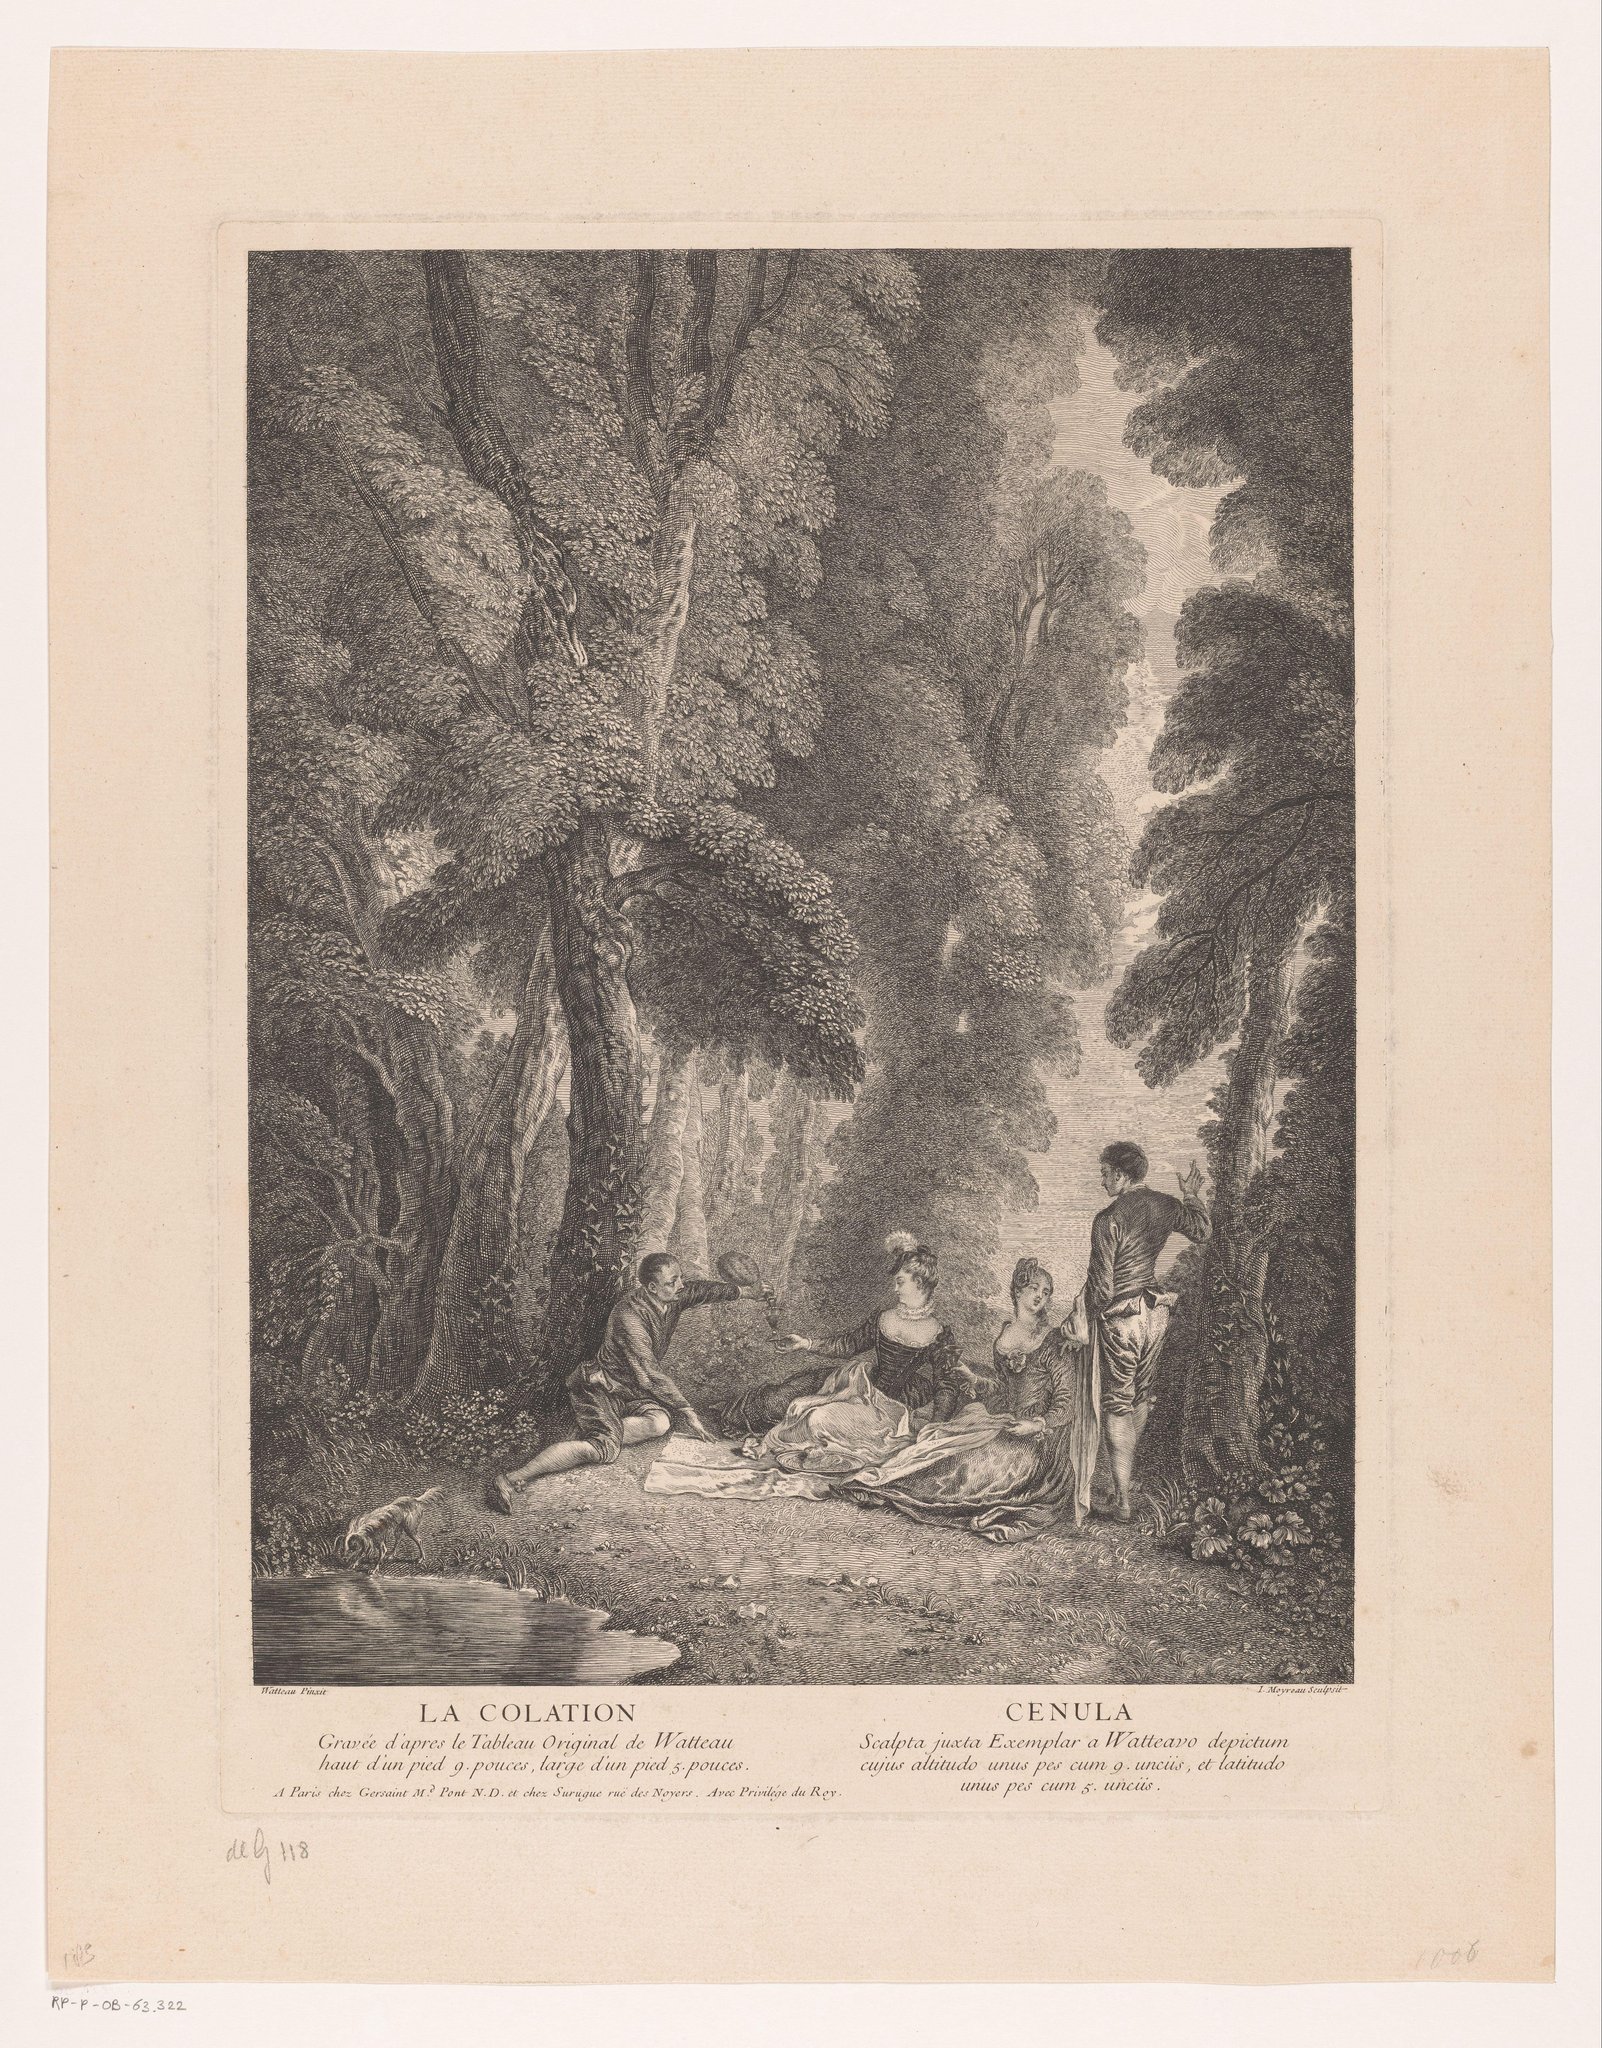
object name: print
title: Picknick in een bos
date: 1729-1731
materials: paper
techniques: engraving, etching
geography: france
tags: picnic, alfresco, 'déjeuner sur l'herbe'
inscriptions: collector's mark: Lugt 240, inscription: ‘ft(?) 3200.’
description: Maakt deel uit van een serie van 271 platen naar schilderijen door Watteau, gecoördineerd door Jean de Jullienne en uitgegeven in Parijs tussen ca. 1726 en 1735. Sommige platen werden reeds tijdens Watteau's leven gemaakt. In 1735 werden honderd exemplaren van de voltooide serie uitgegeven. Dit betreft plaat 66.